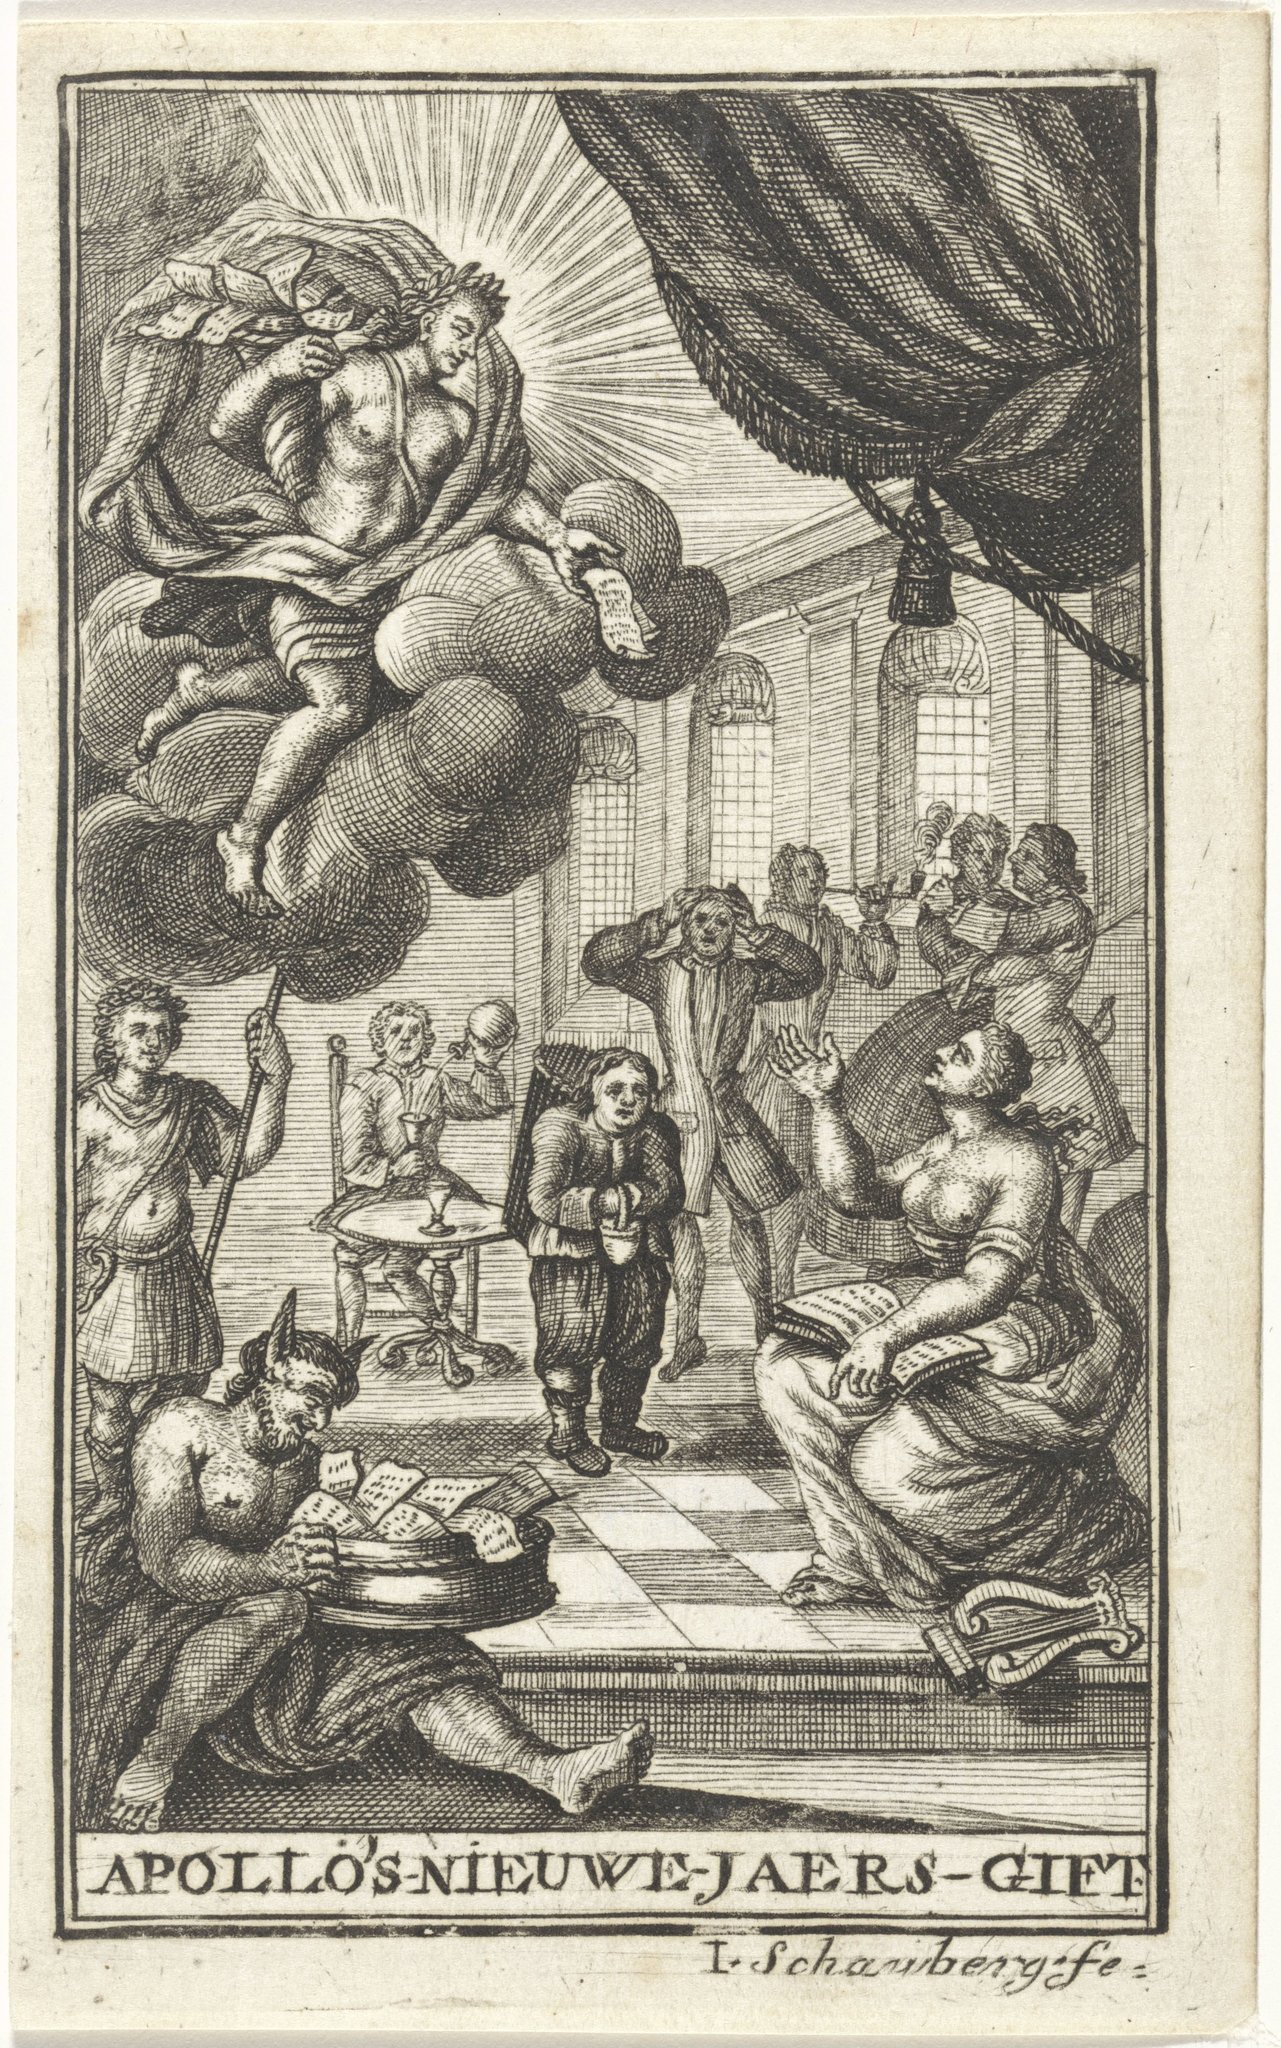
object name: titelblad, titelpagina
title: Titelpagina voor: Anoniem. Apollo's nieuwe-jaers-gift. Aen het bekoorlyke Hollandsche jufferschap, 1742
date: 1742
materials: paper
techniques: engraving, etching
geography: antwerp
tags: (story of) momus, (story of) apollo (phoebus), title-page, celebration meal, feast, banquet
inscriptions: collector's mark: Lugt 2760, collector's mark: Lugt 2166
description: Rechts zit de personificatie van de zangkunst in de gedaante van een vrouw met ontblote borsten en een lier. Op haar schoot ligt een opengeslagen boek. Ze kijkt omhoog naar Apollo die op een wolk in haar richting vliegt. Hij houdt een hoorn des overvloeds vast, gevuld met papier en enkele losse vellen. De rest van het gezelschap kijkt rokend en drinkend toe. Linksvoor probeert Momus verschillende pagina's te ziften. Hij draagt ezelsoren.